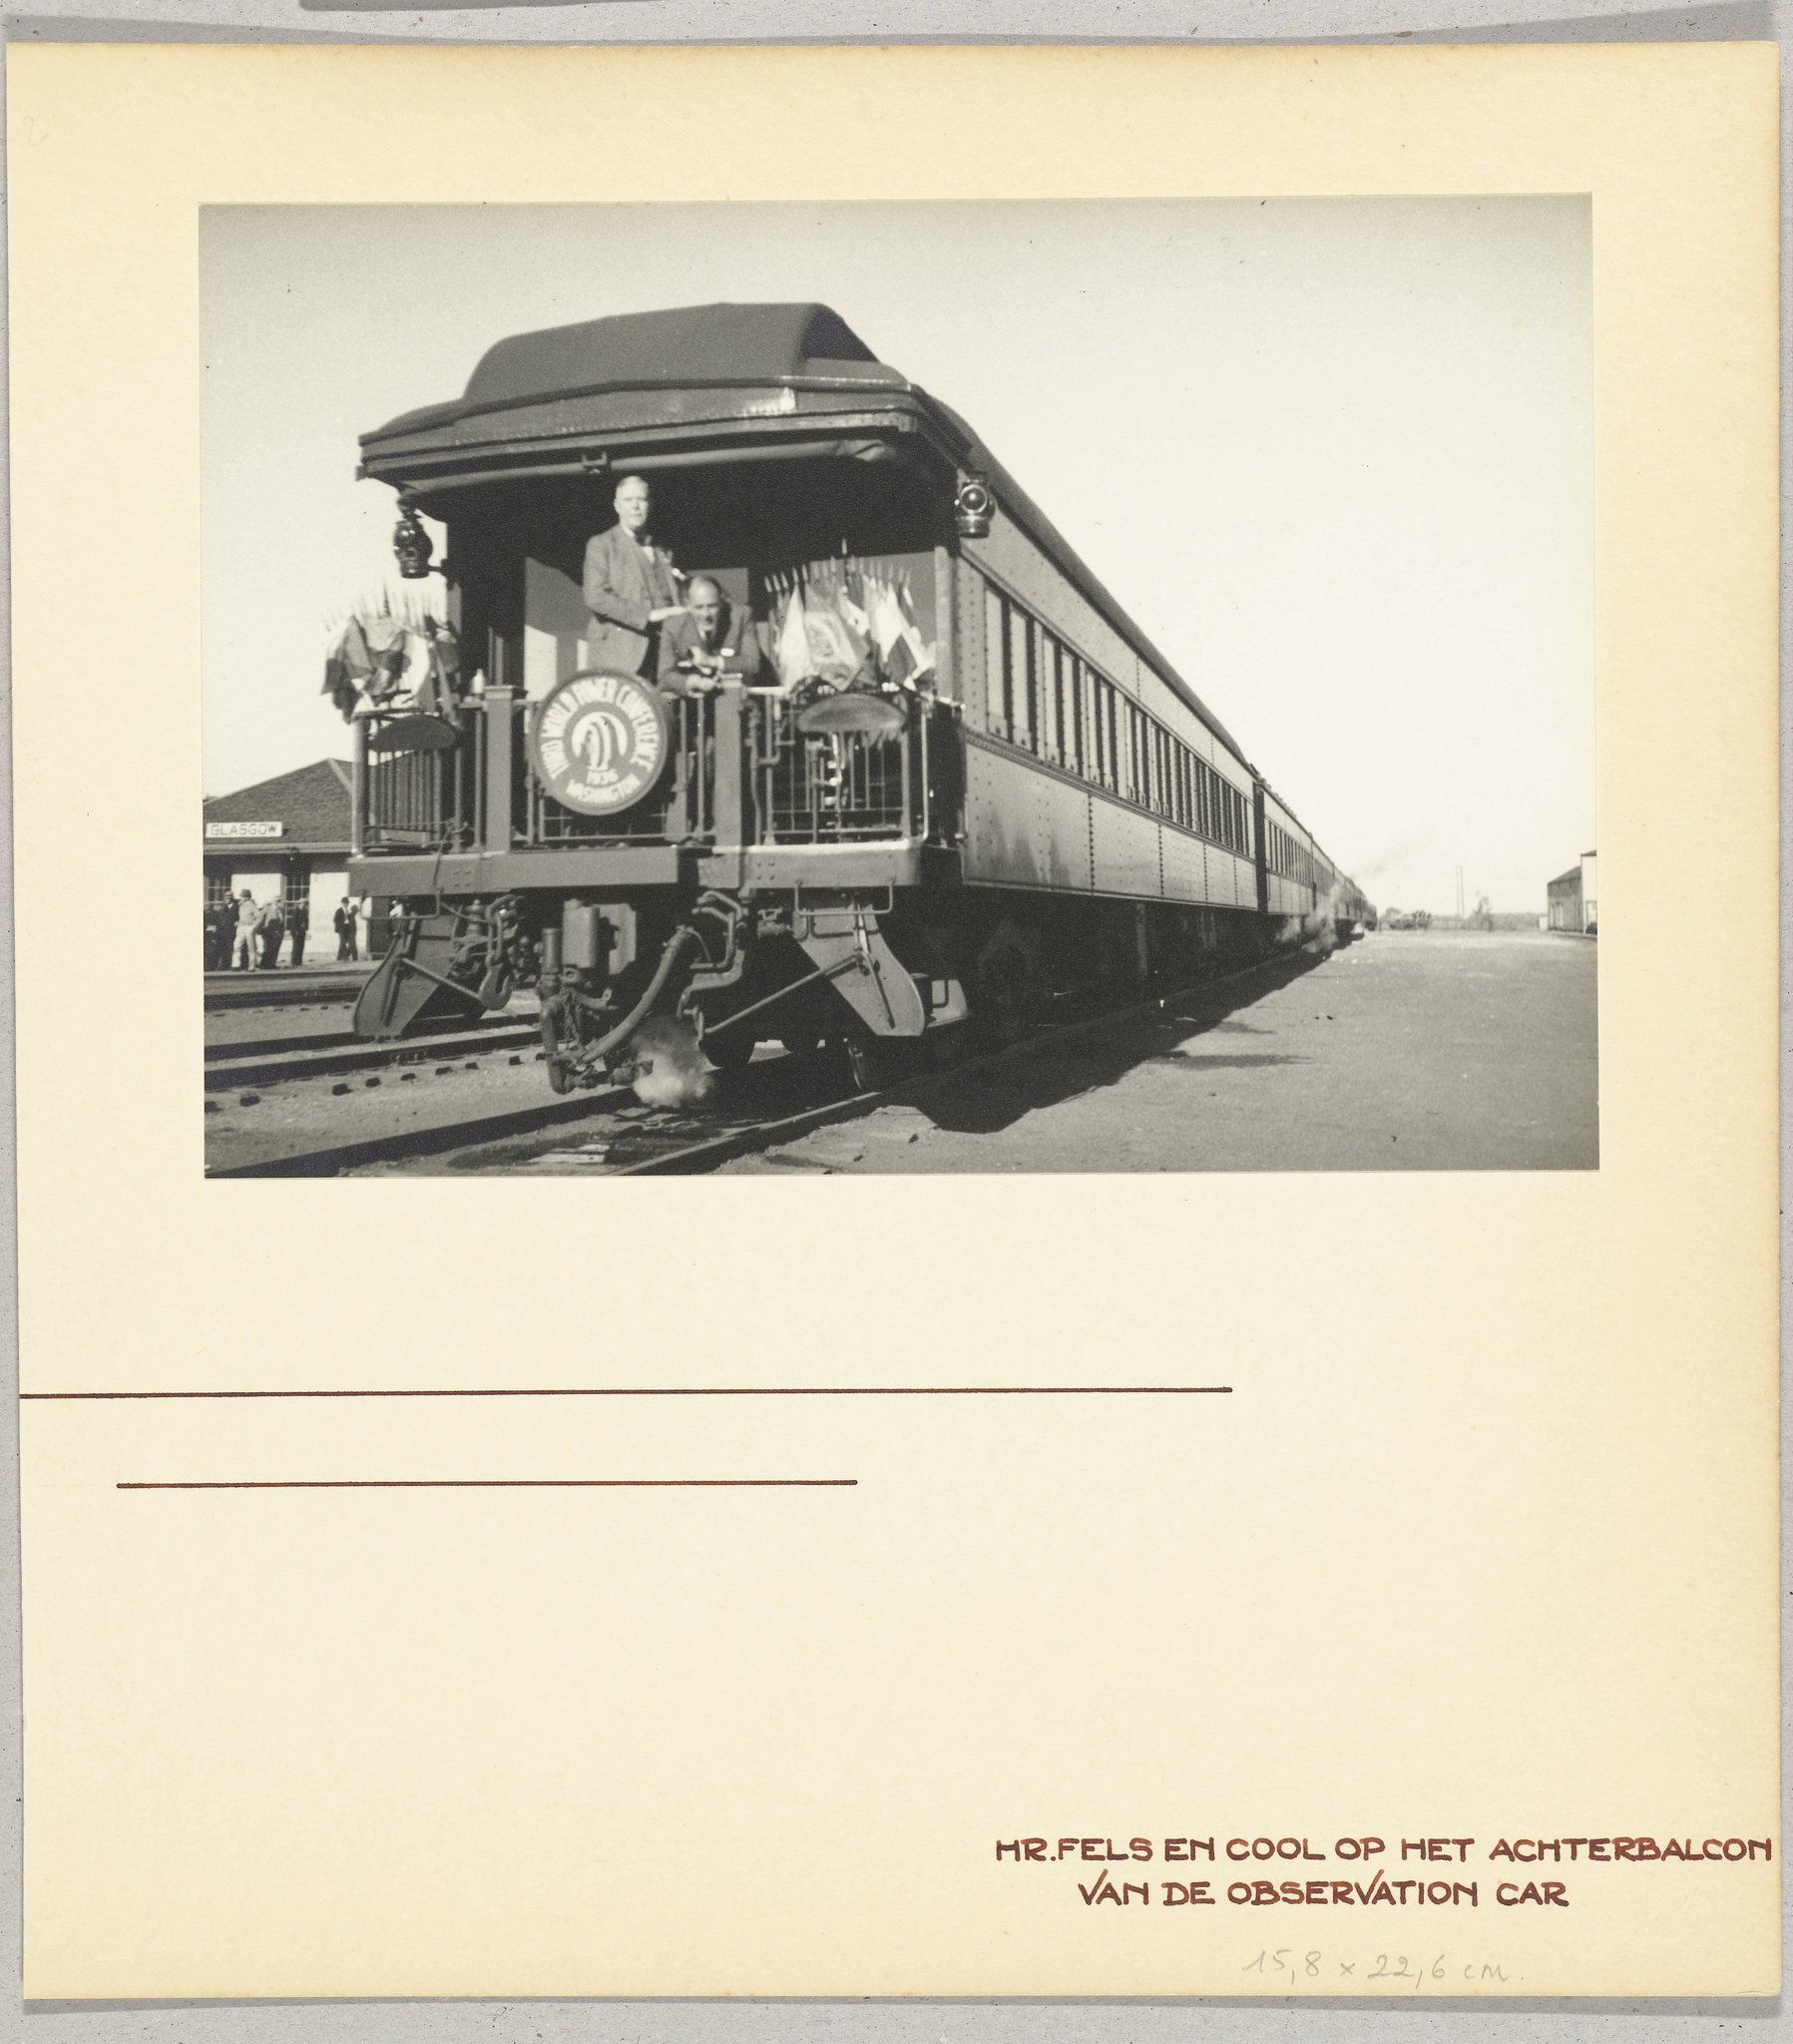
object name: photograph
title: Wouter Cool Jr en J.J. [?] Fels op het achterbalkon van de trein waarmee de rondreis door de Verenigde Staten werd gemaakt, bij Glasgow, Montana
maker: wouter cool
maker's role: engineer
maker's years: 1877-1947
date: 1936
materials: cardboard, paper, photographic support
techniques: gelatin silver print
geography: united states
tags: passenger train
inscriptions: title: ‘HR. FELS EN COOL OP HET ACHTERBALCON / VAN DE OBSERVATION CAR’